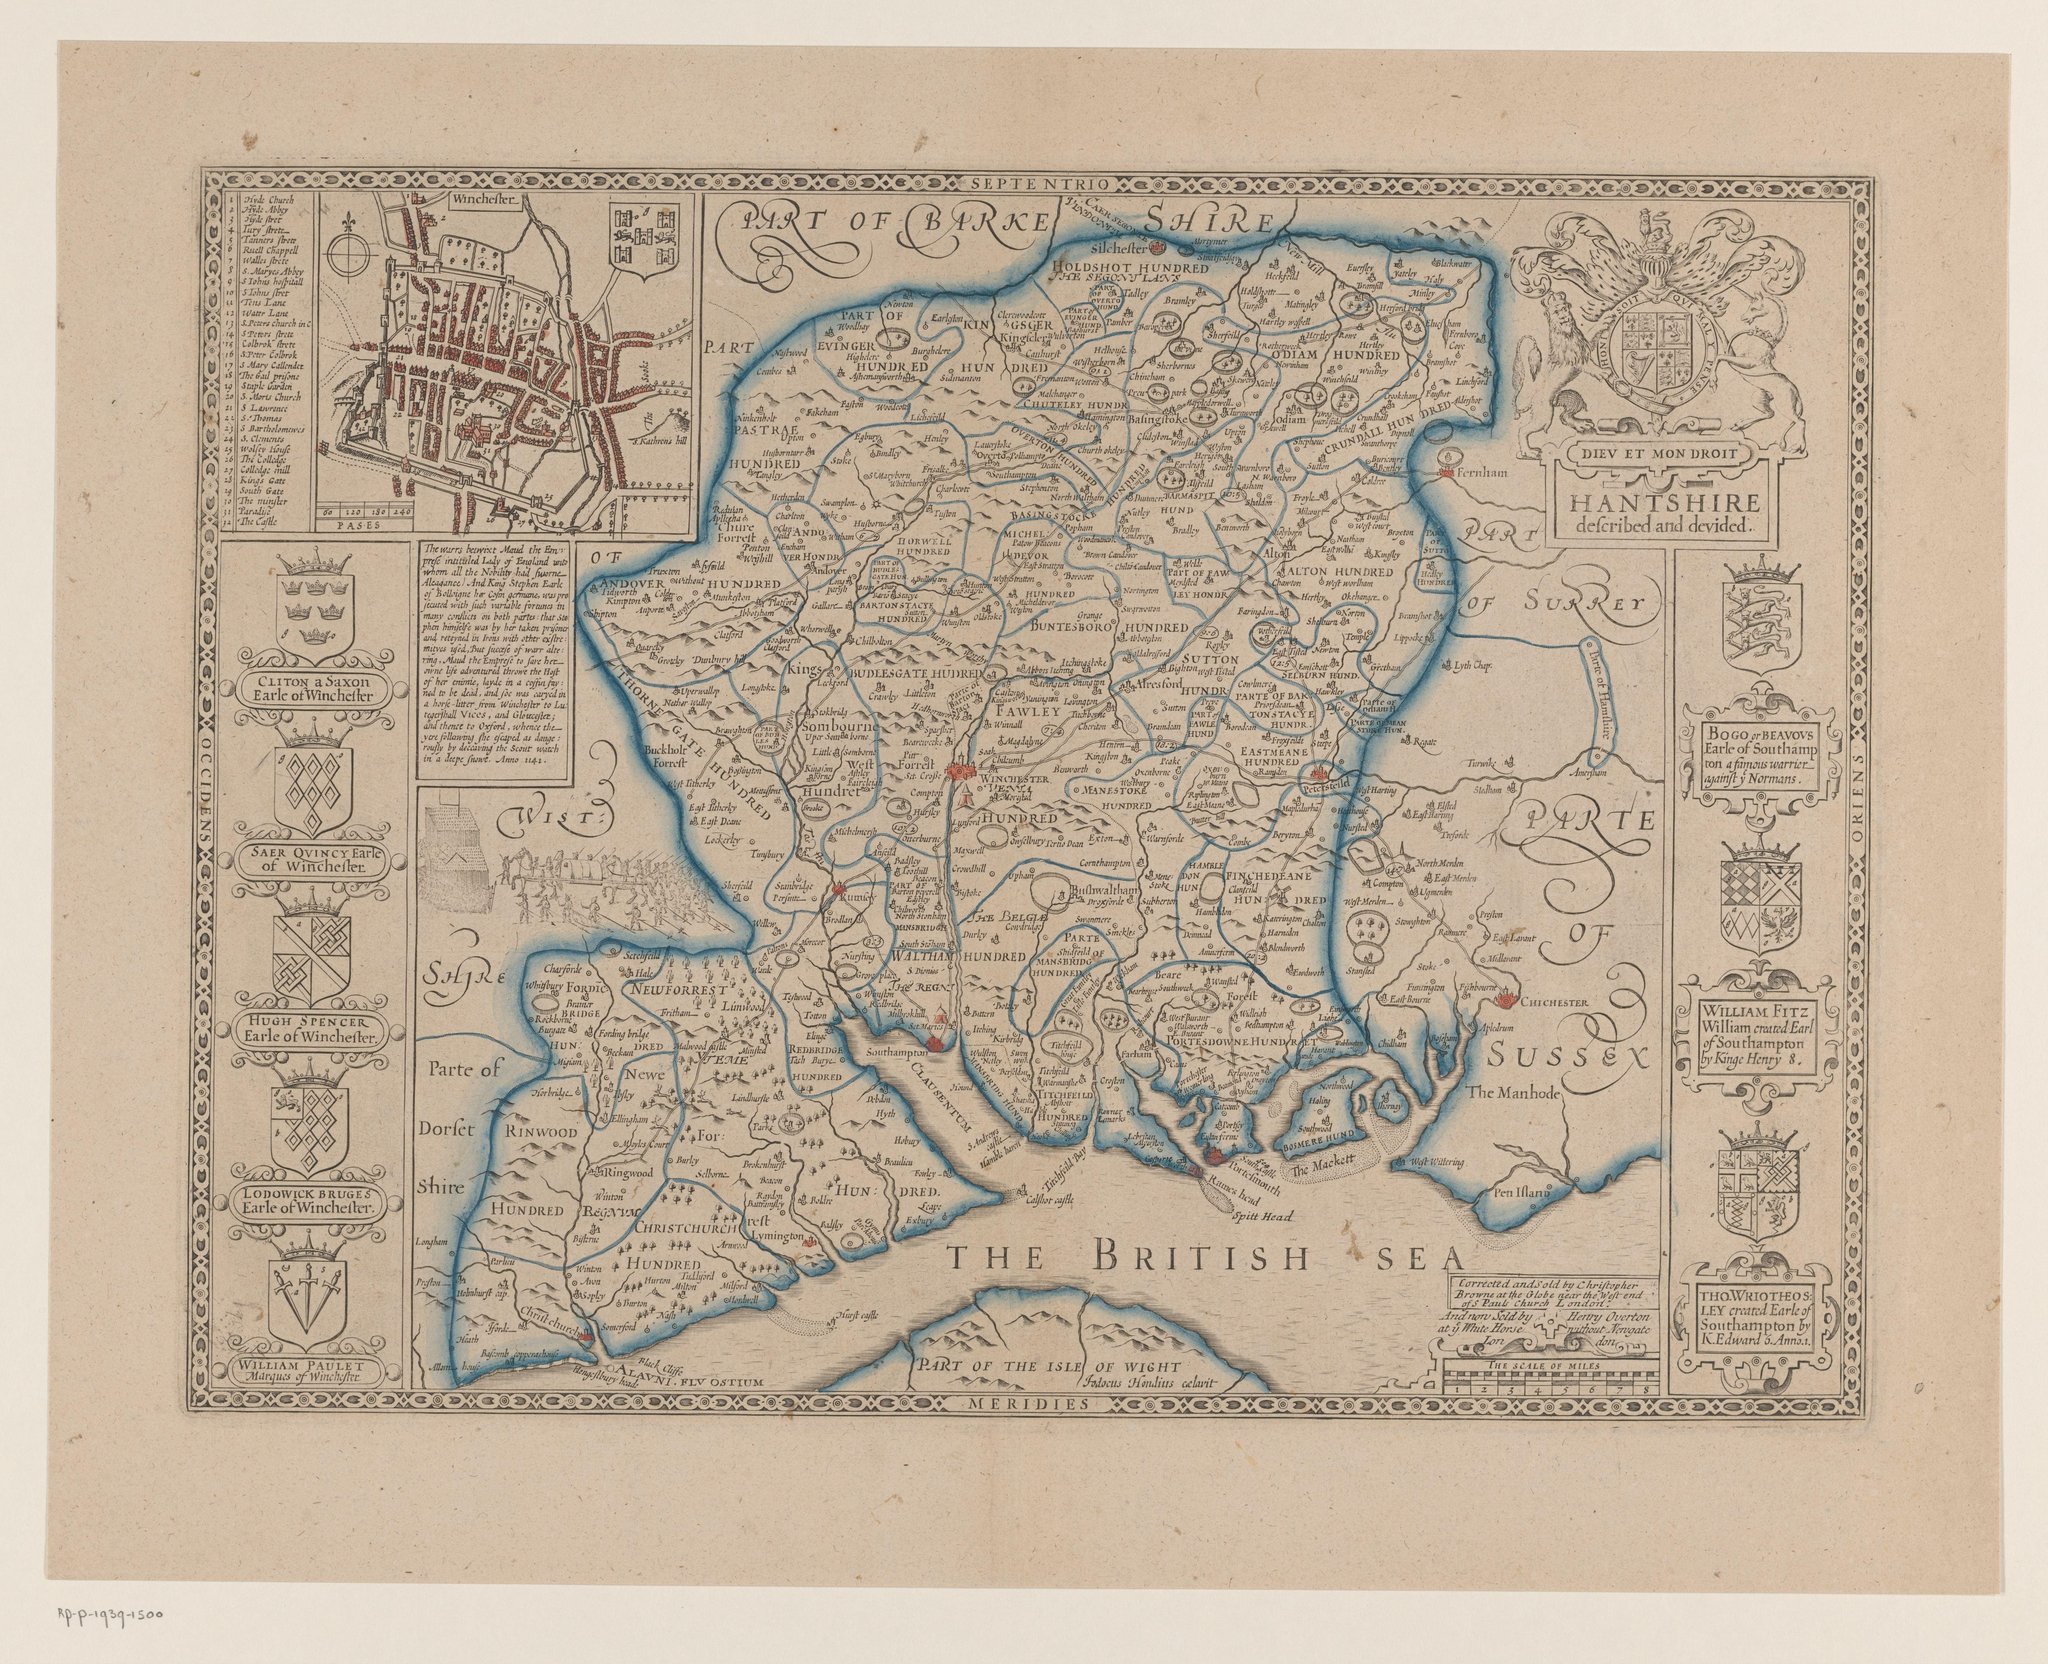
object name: map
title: Kaart van de zuidkust van Engeland met een gedeelte van het eiland Wight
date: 1710-1751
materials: paper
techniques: engraving, etching, hand coloring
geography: london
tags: maps of separate countries or regions, maps of cities, armorial bearing, heraldry, england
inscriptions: collector's mark: Lugt 2760, collector's mark: Lugt 2166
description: Prent ook gebruikt in Henry Overton's editie van John Speeds atlas 'England Fully Described in a Compleat Sett of Mapps of Ye County's of England and Wales (...)'. Deze atlas is in ieder geval uitgegen tussen 1710 en 1743.